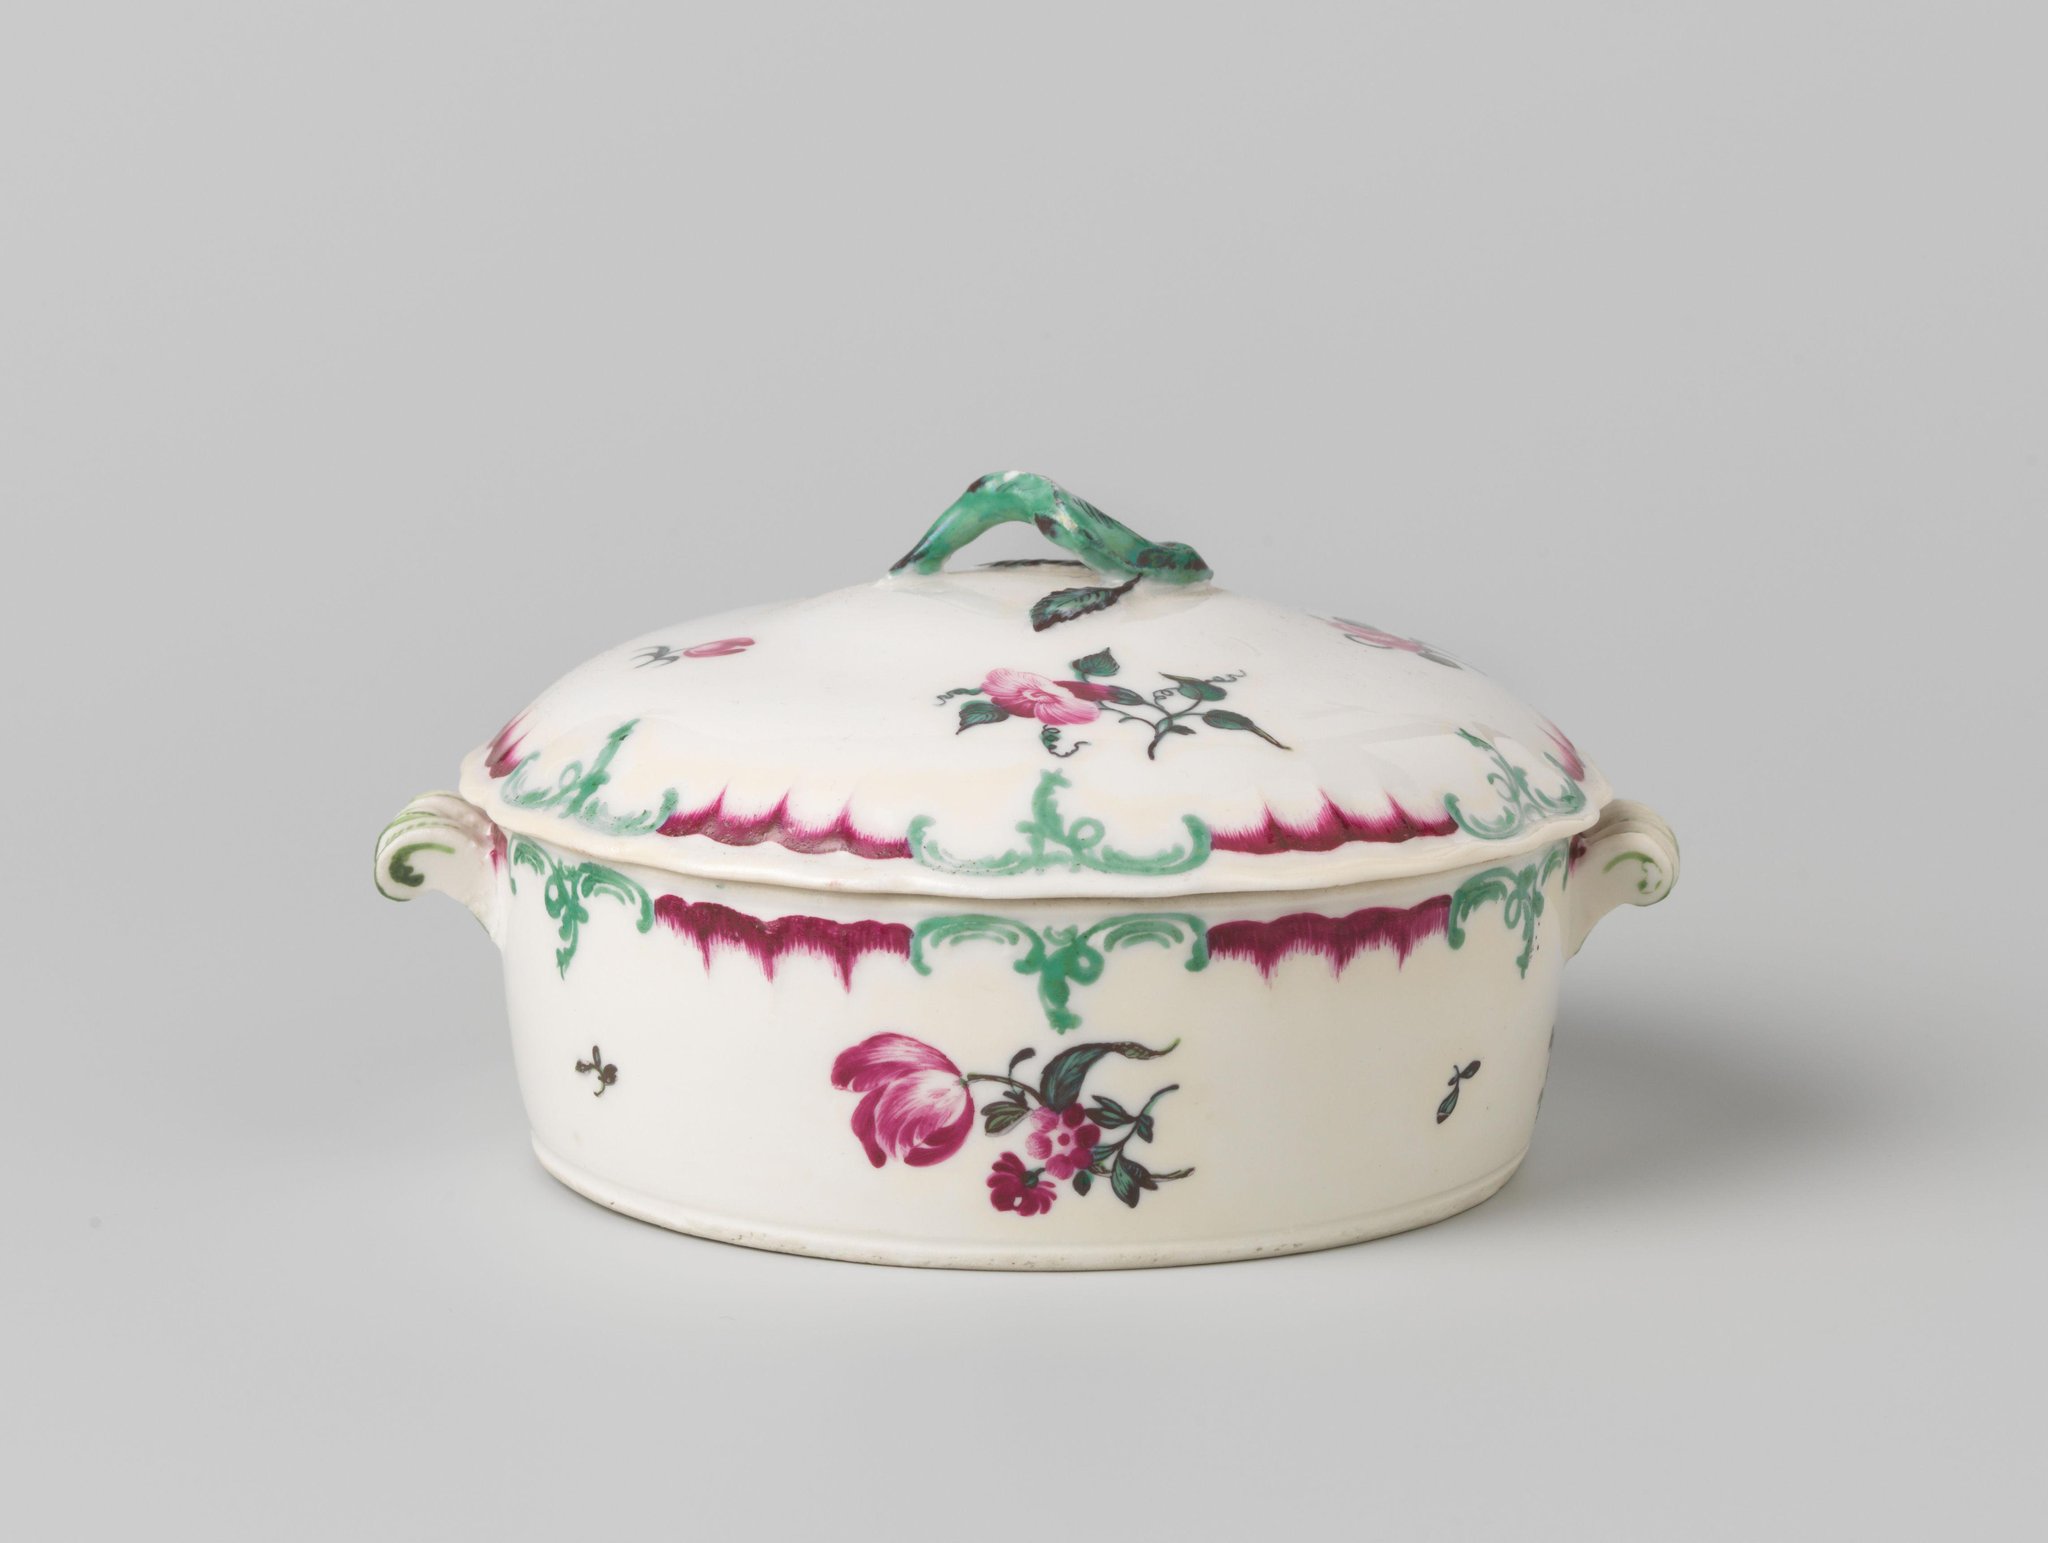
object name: butter dish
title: Botervloot, beschilderd met bloemtakjes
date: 1778-1782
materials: porcelain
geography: loosdrecht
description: Butter dish and cover. Porcelain. Loosdrecht, c. 1778 - 1782. Factory of Joannes de Mol.